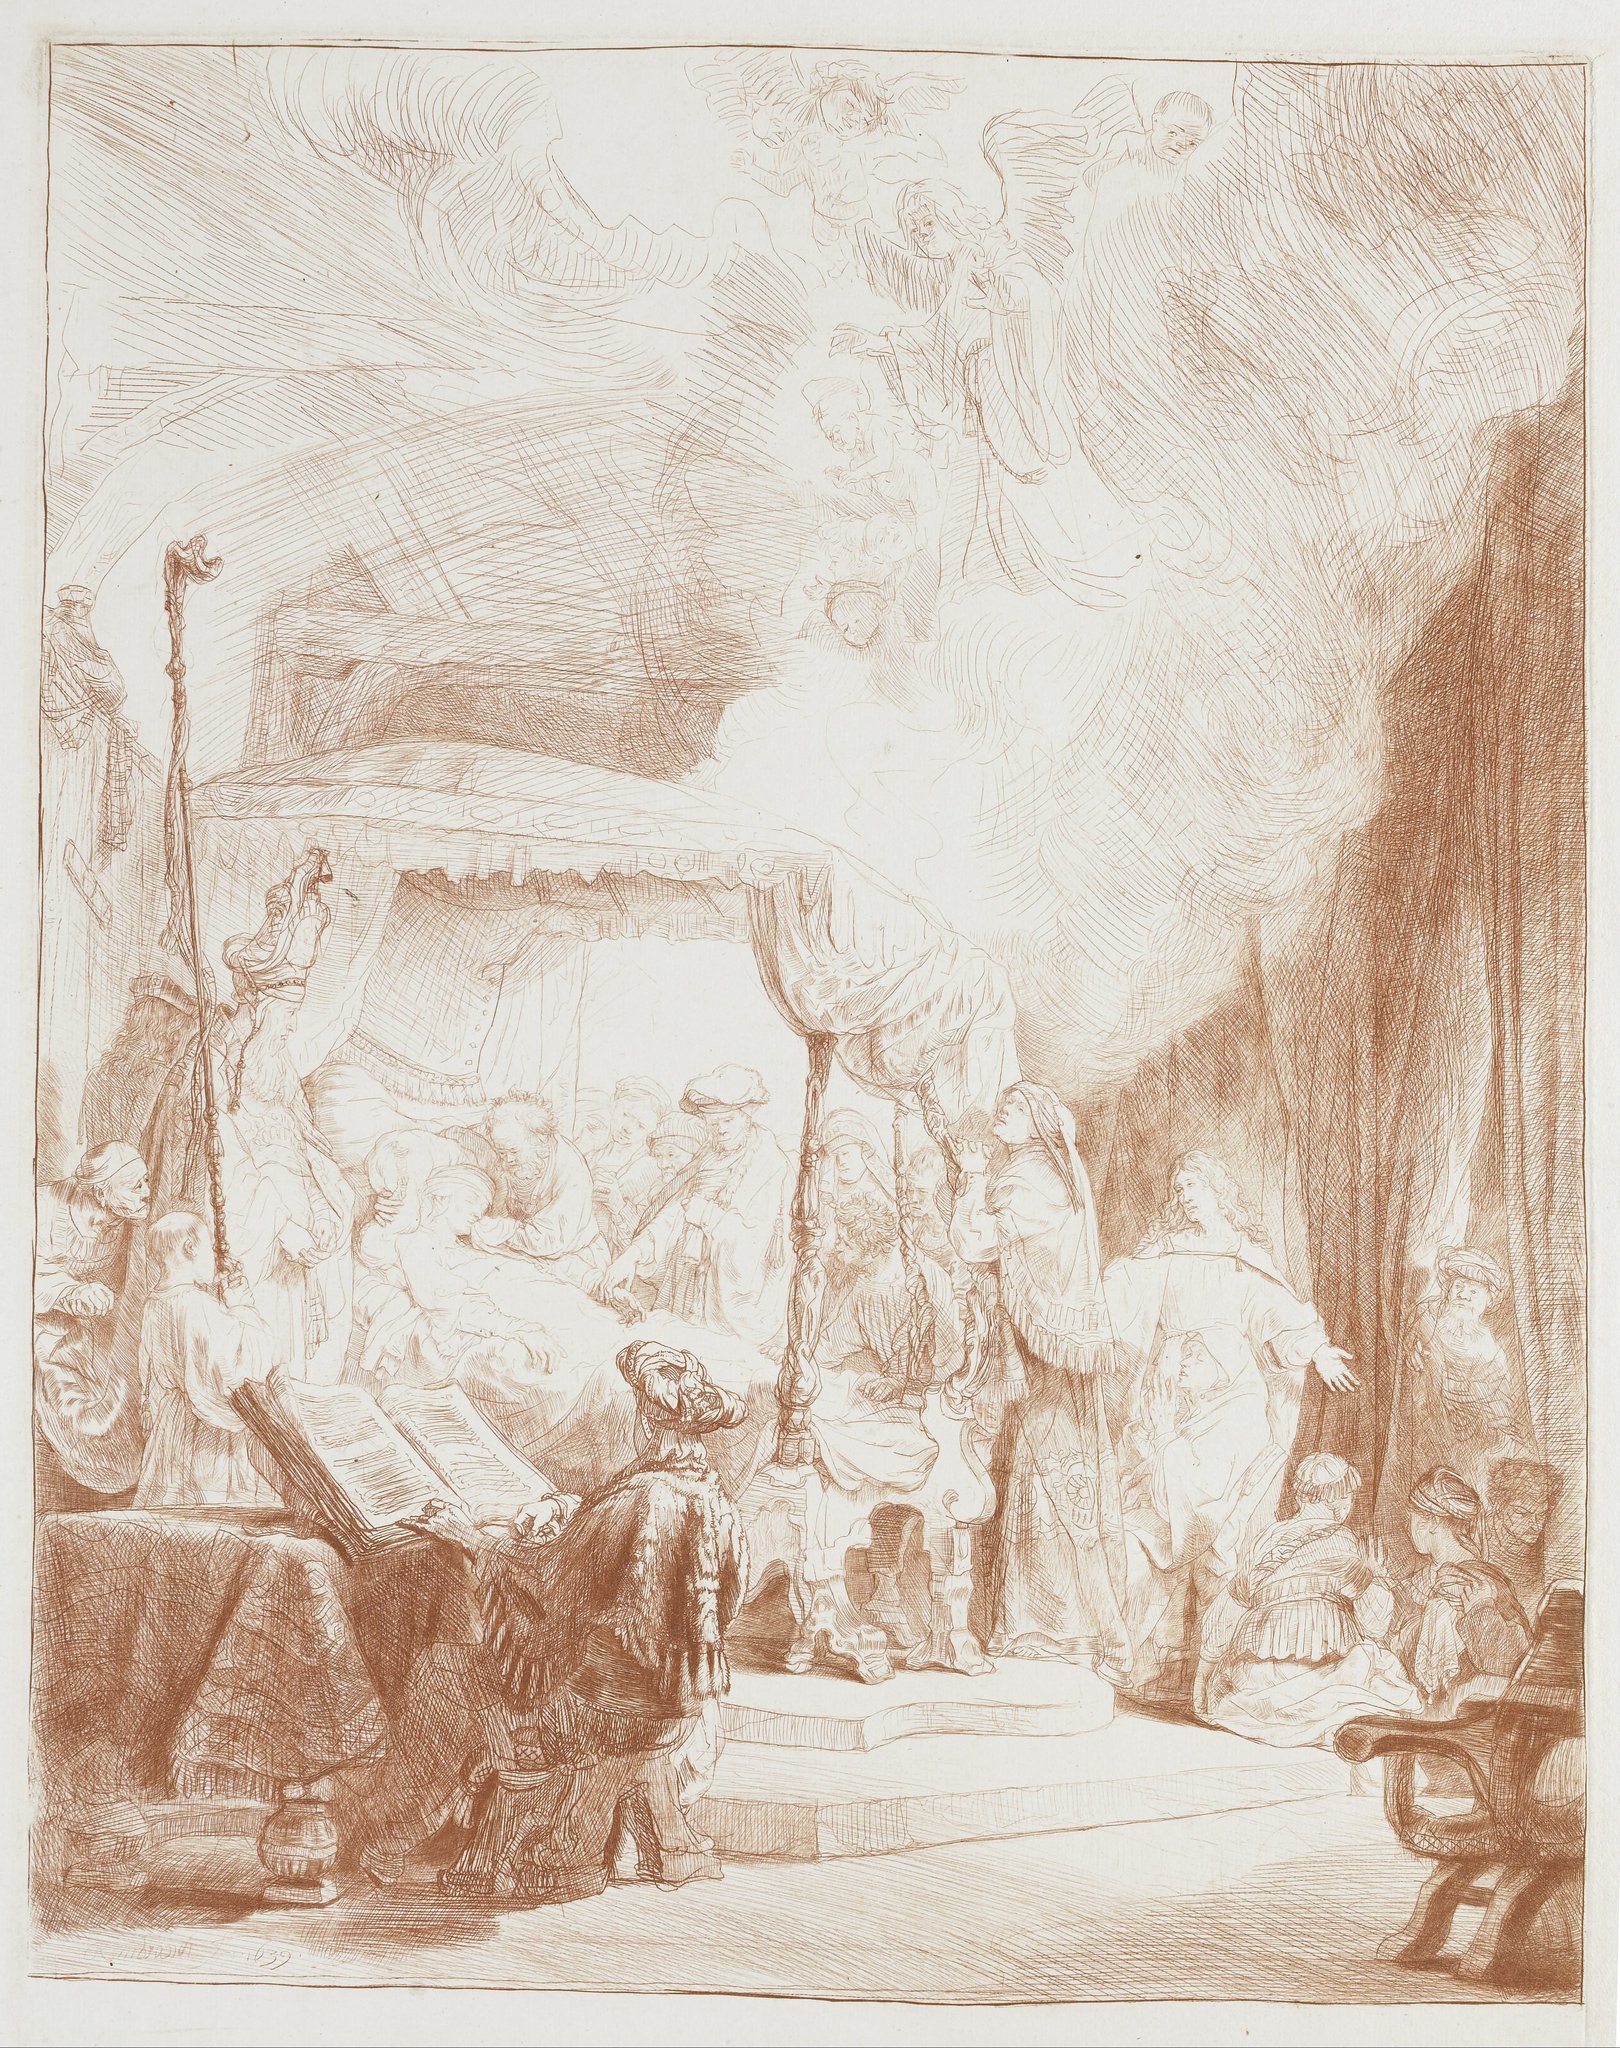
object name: print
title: The death of the Virgin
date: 1639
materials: paper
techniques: drypoint, etching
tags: the dormition: mary on her deathbed; the apostles are gathered around her (john the evangelist may be shown sleeping or dreaming)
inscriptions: mark: Lugt 2228, signature and date: ‘Rembrandt f 1639’